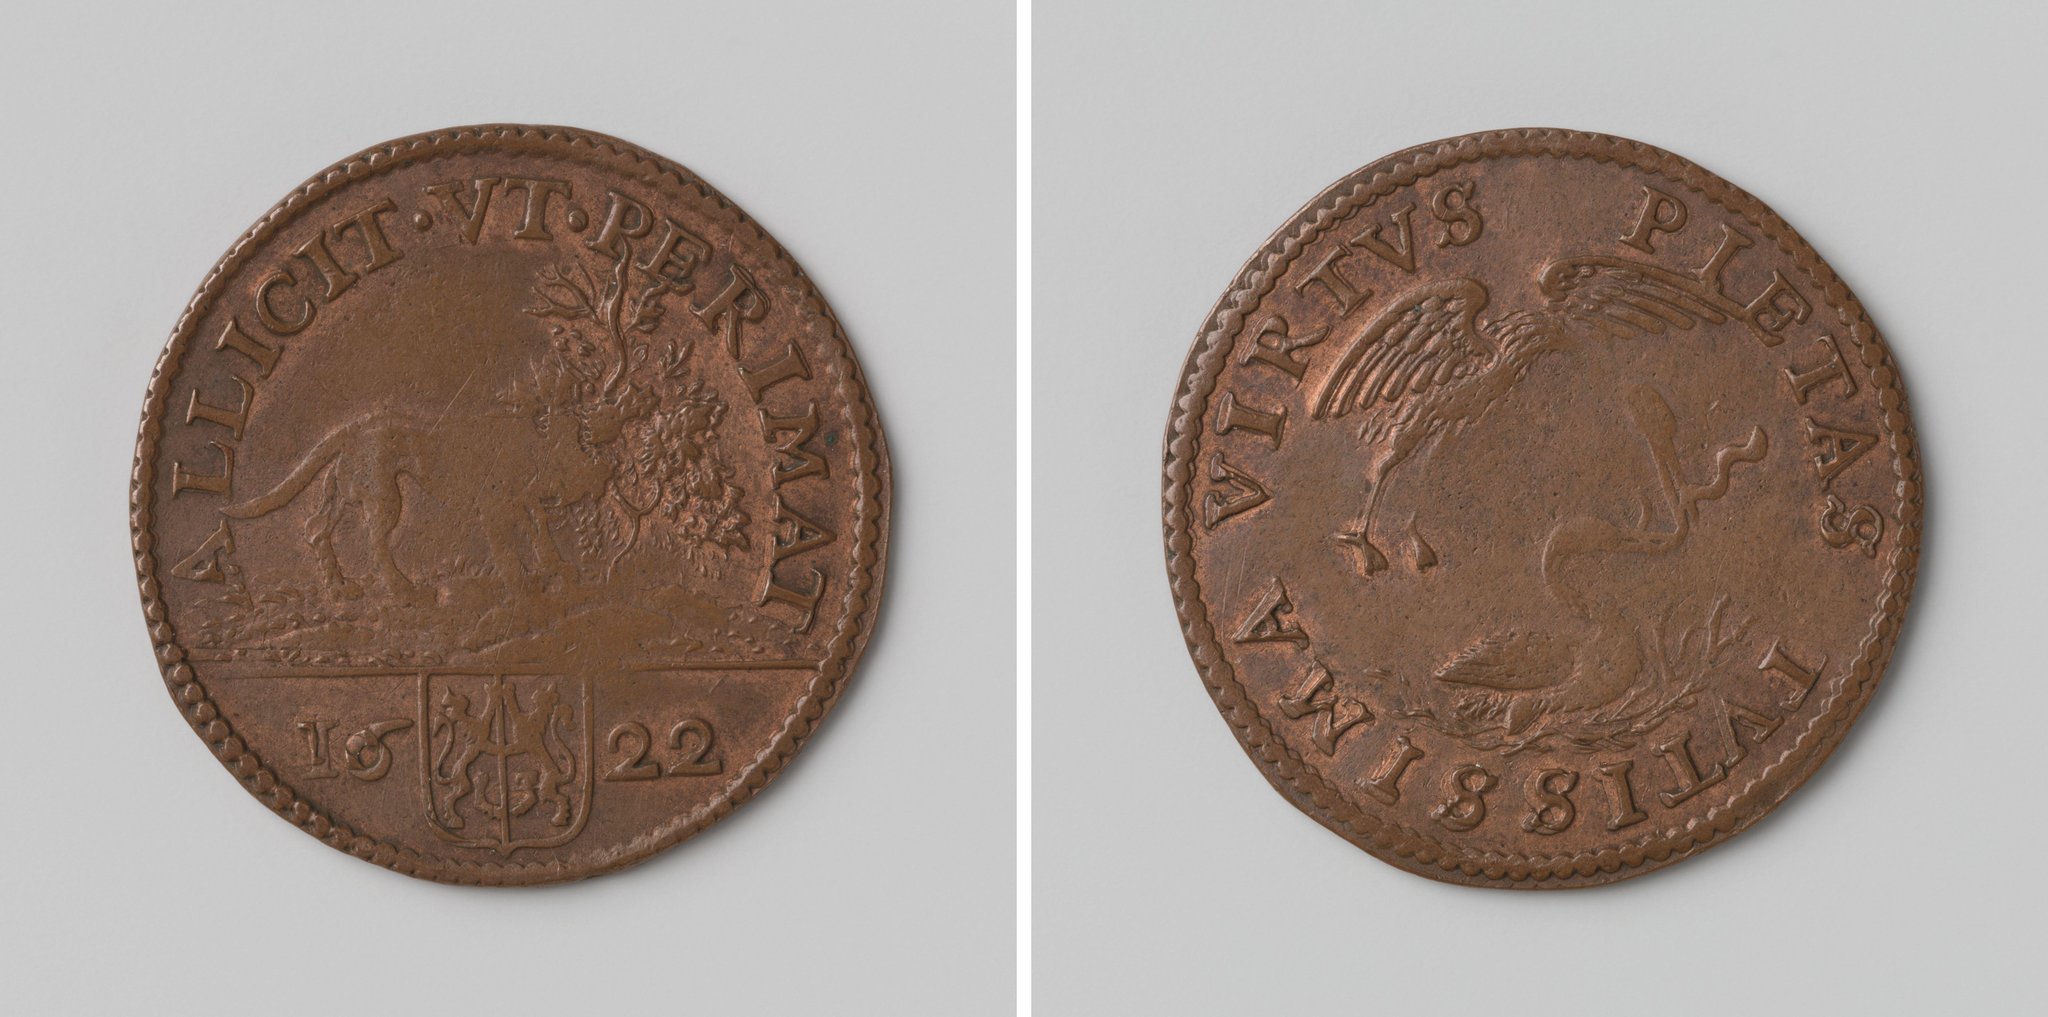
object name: jeton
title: Allegorische rekenpenning, geslagen op last van de Staten van Gelderland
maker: Anonymous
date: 1622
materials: copper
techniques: striking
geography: netherlands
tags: gelderland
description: Koperen penning. Voorzijde: leeuw eet druiven van struik binnen omschrift; afsnede: wapenschild tussen jaartal. Keerzijde: zwaan brengt zijn jong, dat op nest zit een worm binnen omschrift